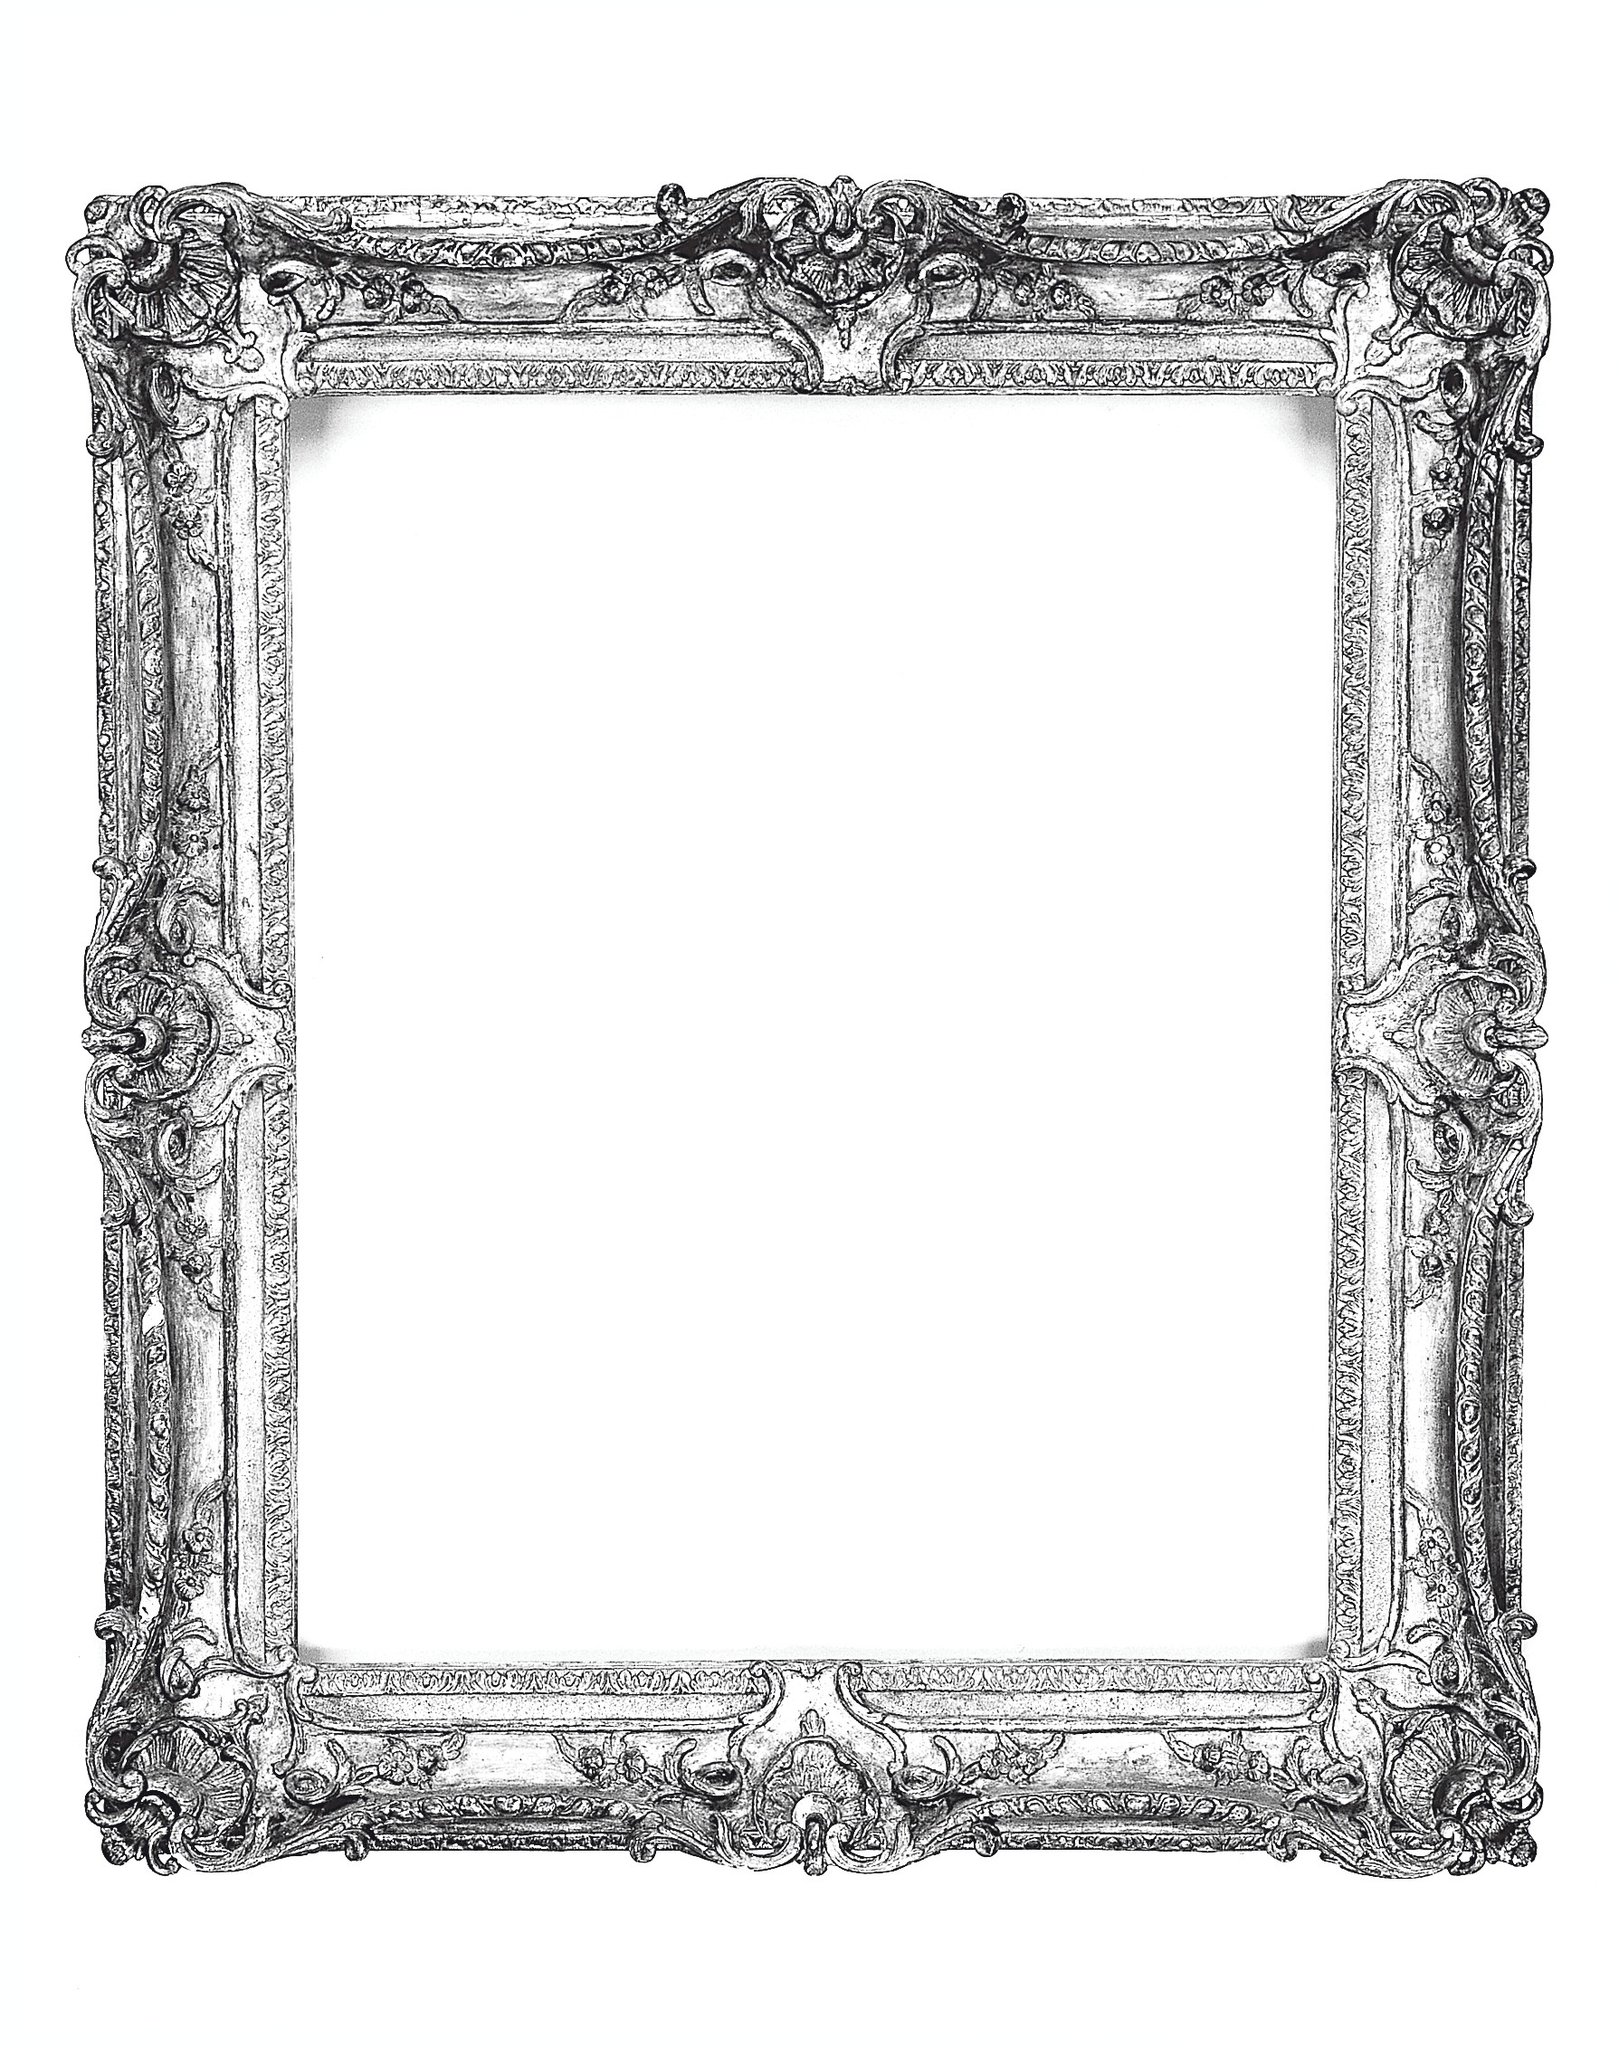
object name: frame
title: Swept frame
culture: french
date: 1760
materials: feather, wood